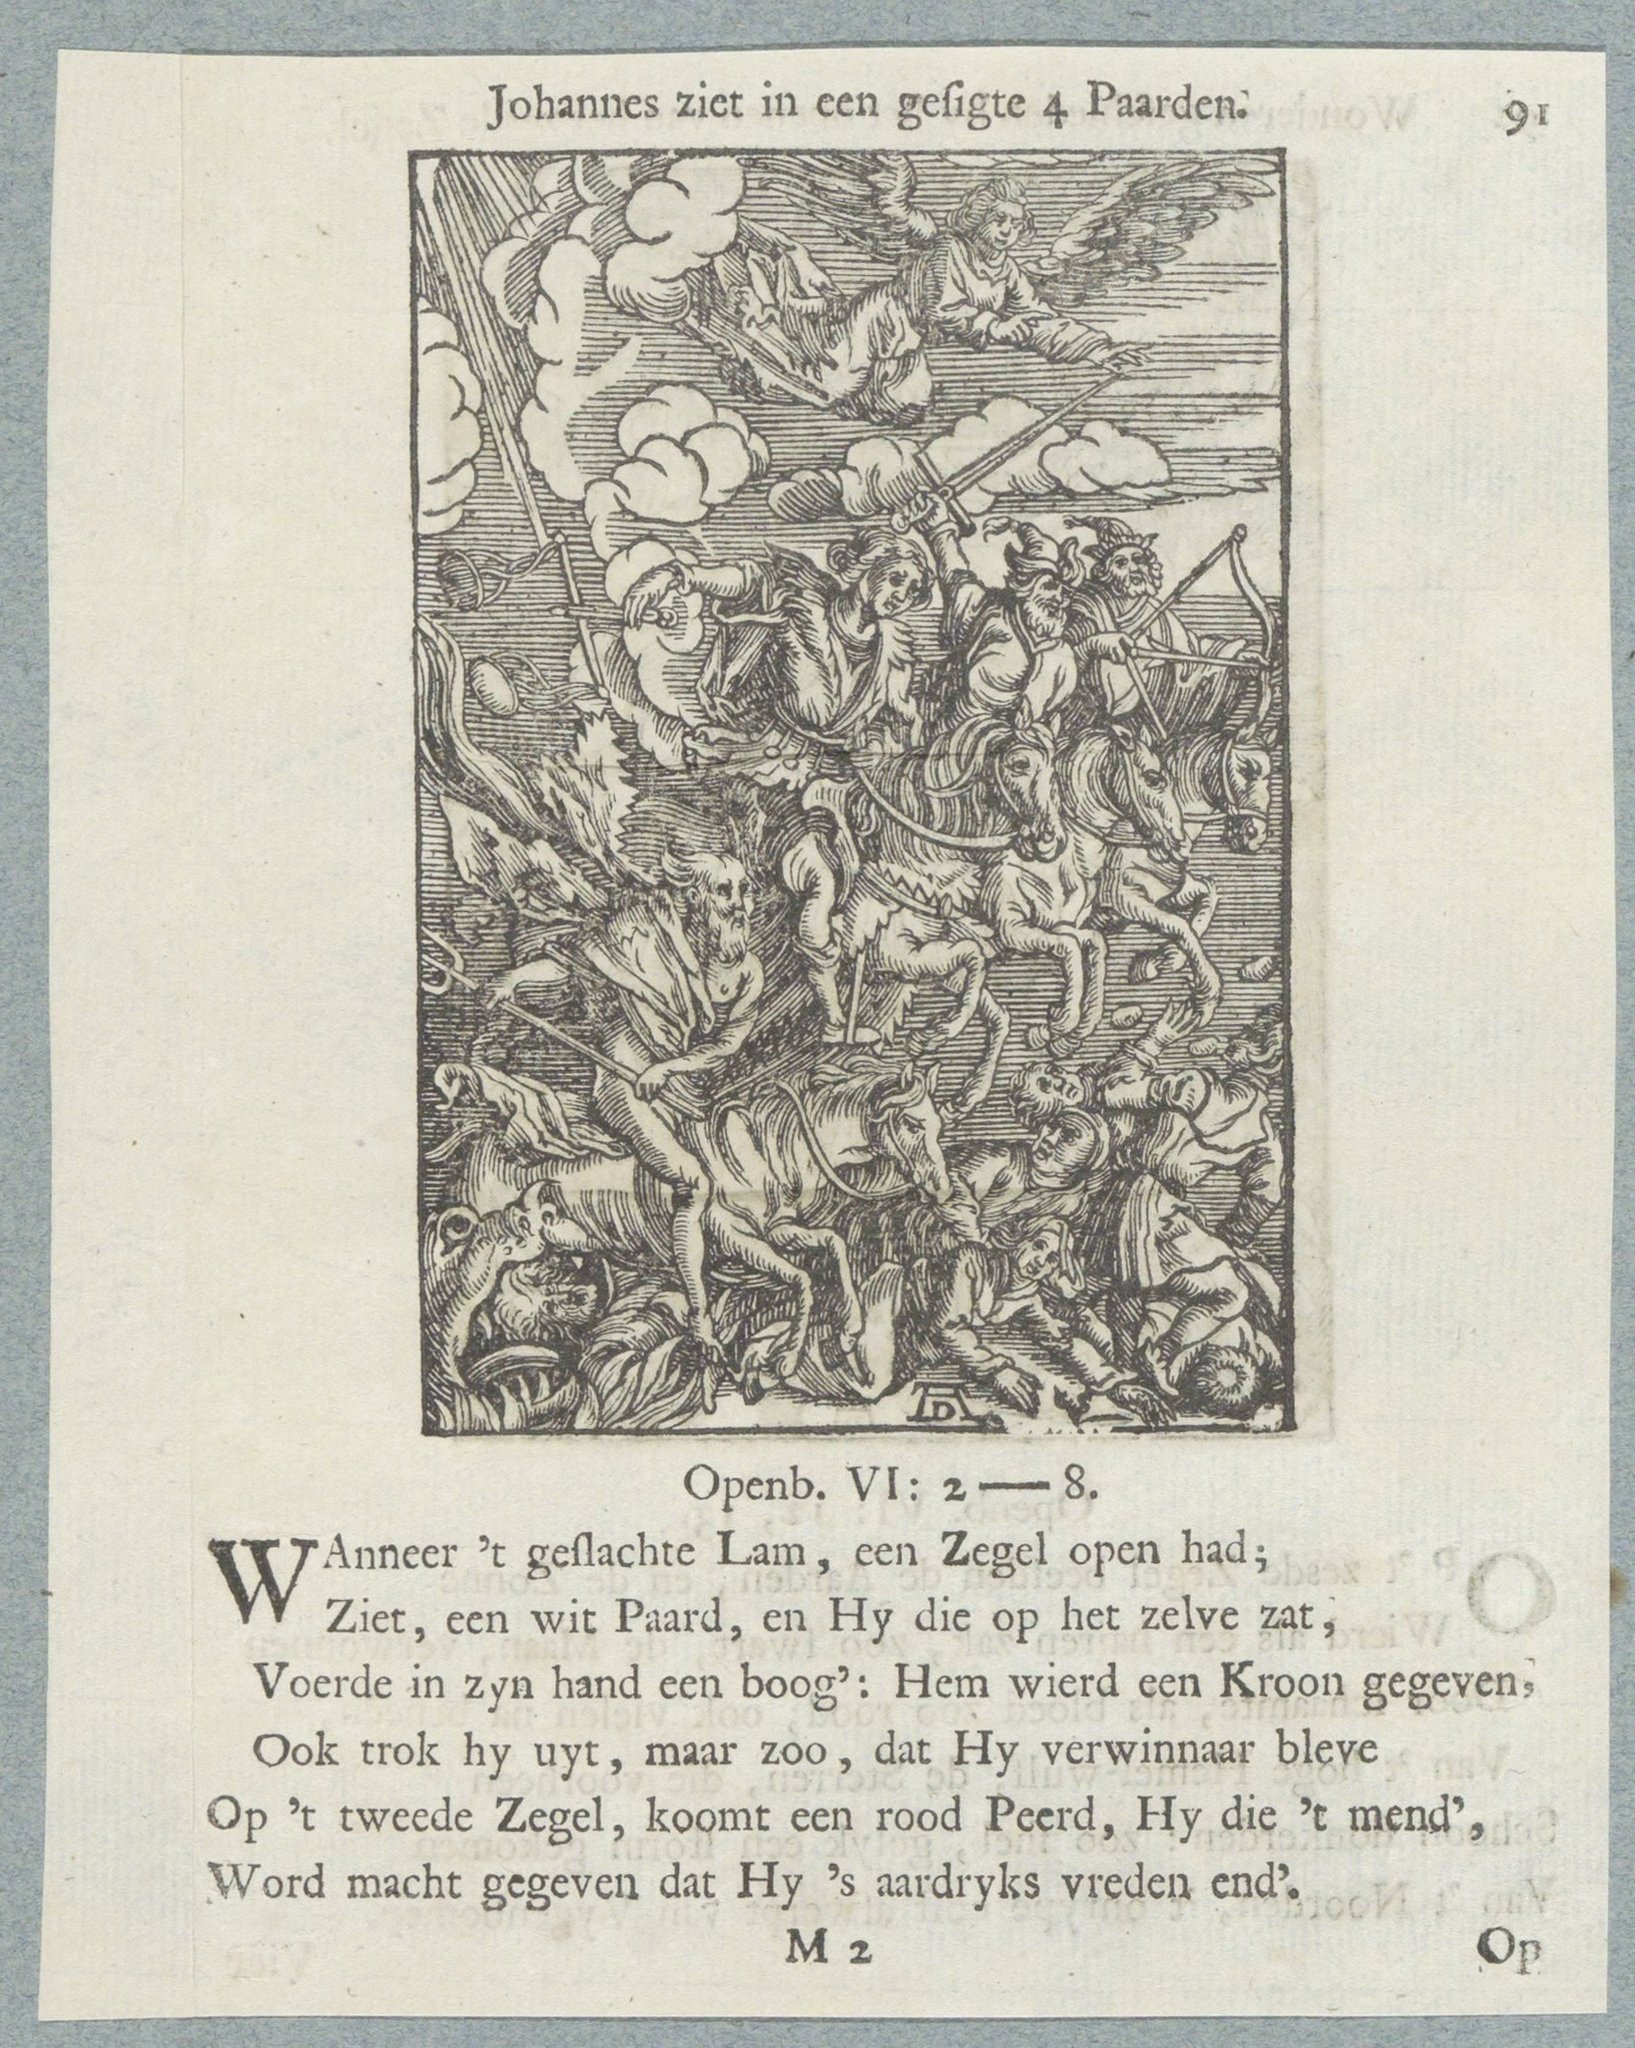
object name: album leaf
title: Johannes ziet in een gesigte 4 paarden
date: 1629-1646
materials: paper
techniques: letterpress printing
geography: nuremberg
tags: the four horsemen of the apocalypse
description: De prent is afkomstig uit: Bybels Lusthof. Amsterdam, J. Klooster, 1740. De prent werd gemaakt voor de uitgaven van P.J. Paets uit Amsterdam, verschenen in de jaren 1629-1648. De prent wordt mogelijk al gebruikt in: Der Zielen Lust-hof. Leuven, I.Jacbosz voor P.J. Paets [= Amsterdam, P.J. Paets], 1629. Ze komt in ieder geval voor in: Het Nieuwe Testament ons Salichmaeckers Jesu Christi. Amsterdam, P.J. Paets, 1646.